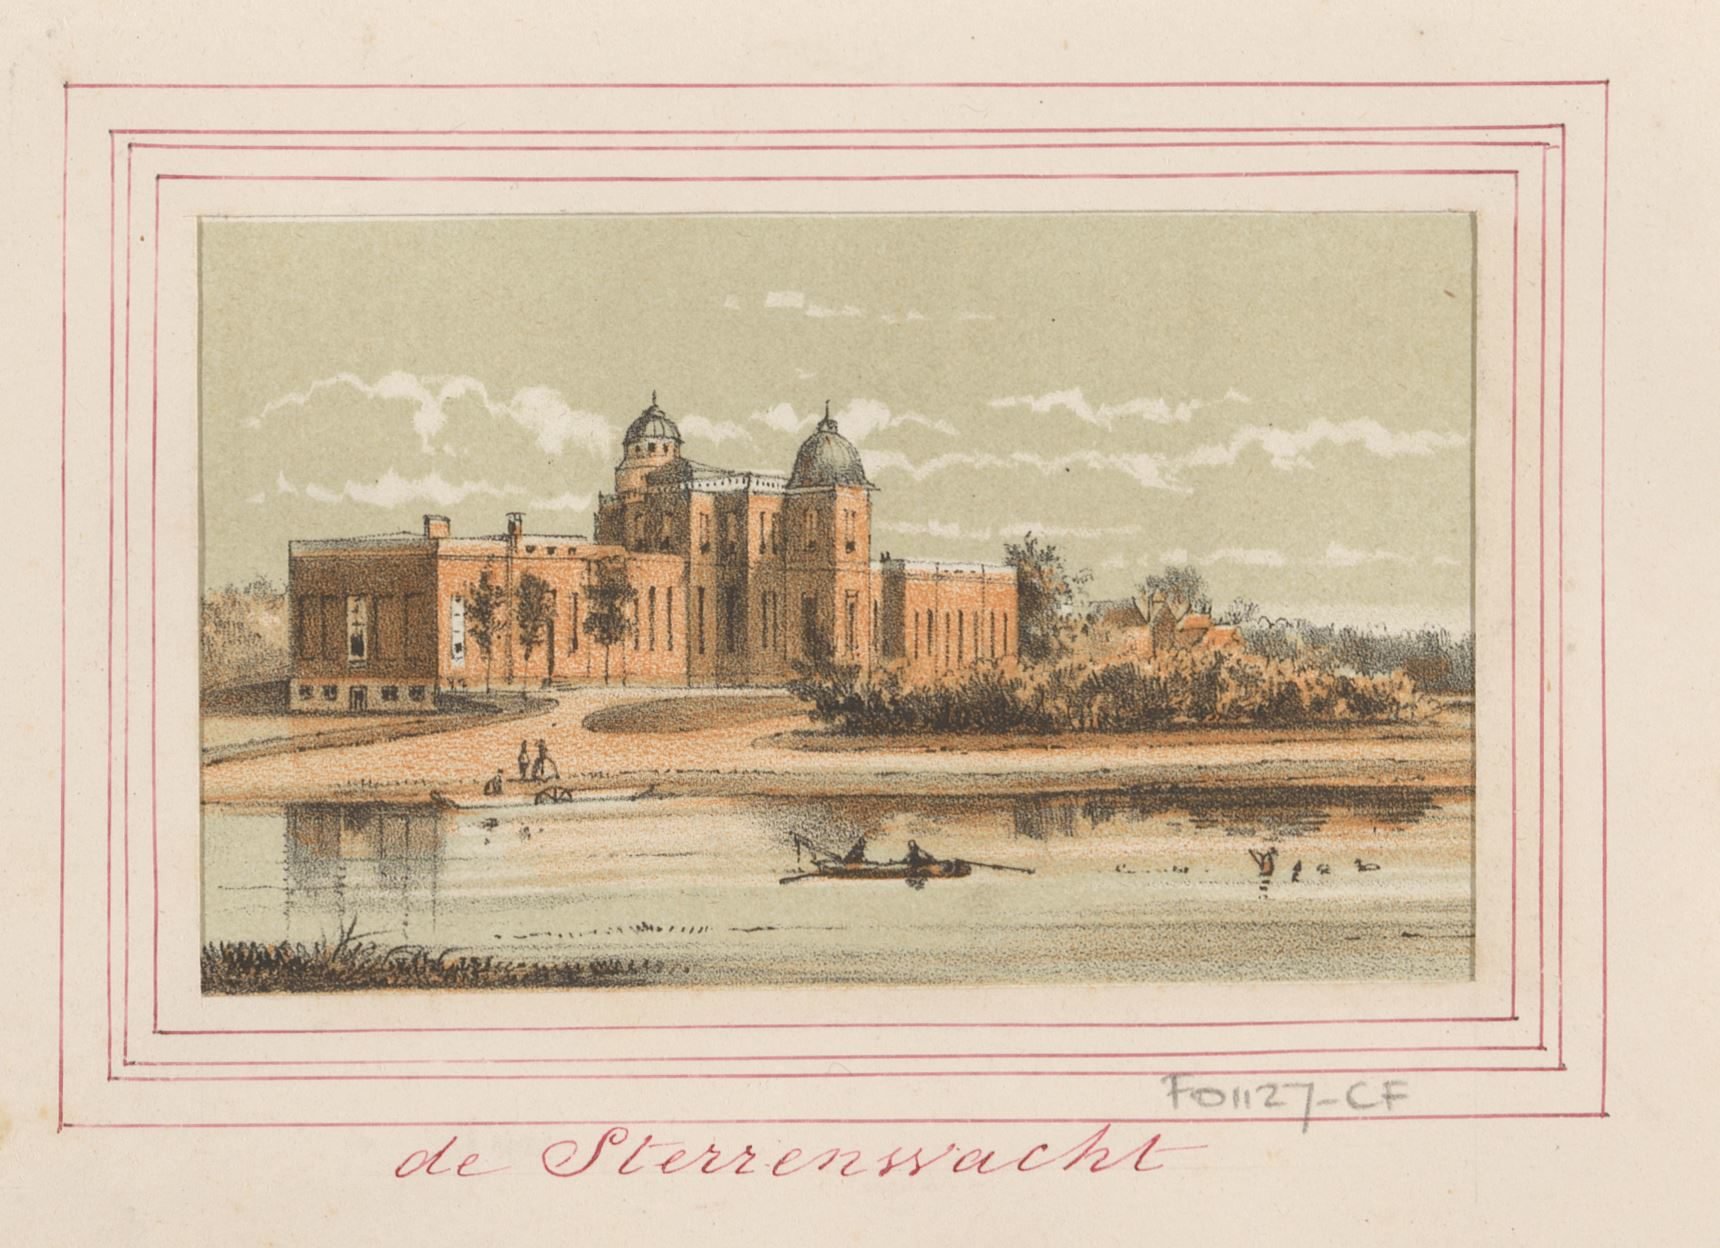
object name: print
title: Gezicht op het gebouw van de Sterrewacht (sterrenwacht) aan de Witte Singel in Leiden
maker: Anonymous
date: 1865-1875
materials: paper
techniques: tone lithography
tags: observatory (~ astronomy), canals, waters (in city), leiden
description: Onderdeel van Album met foto's en litho's van bezienswaardigheden in Noord- en Zuid-Hollandse steden, schilderijen en klederdrachten.